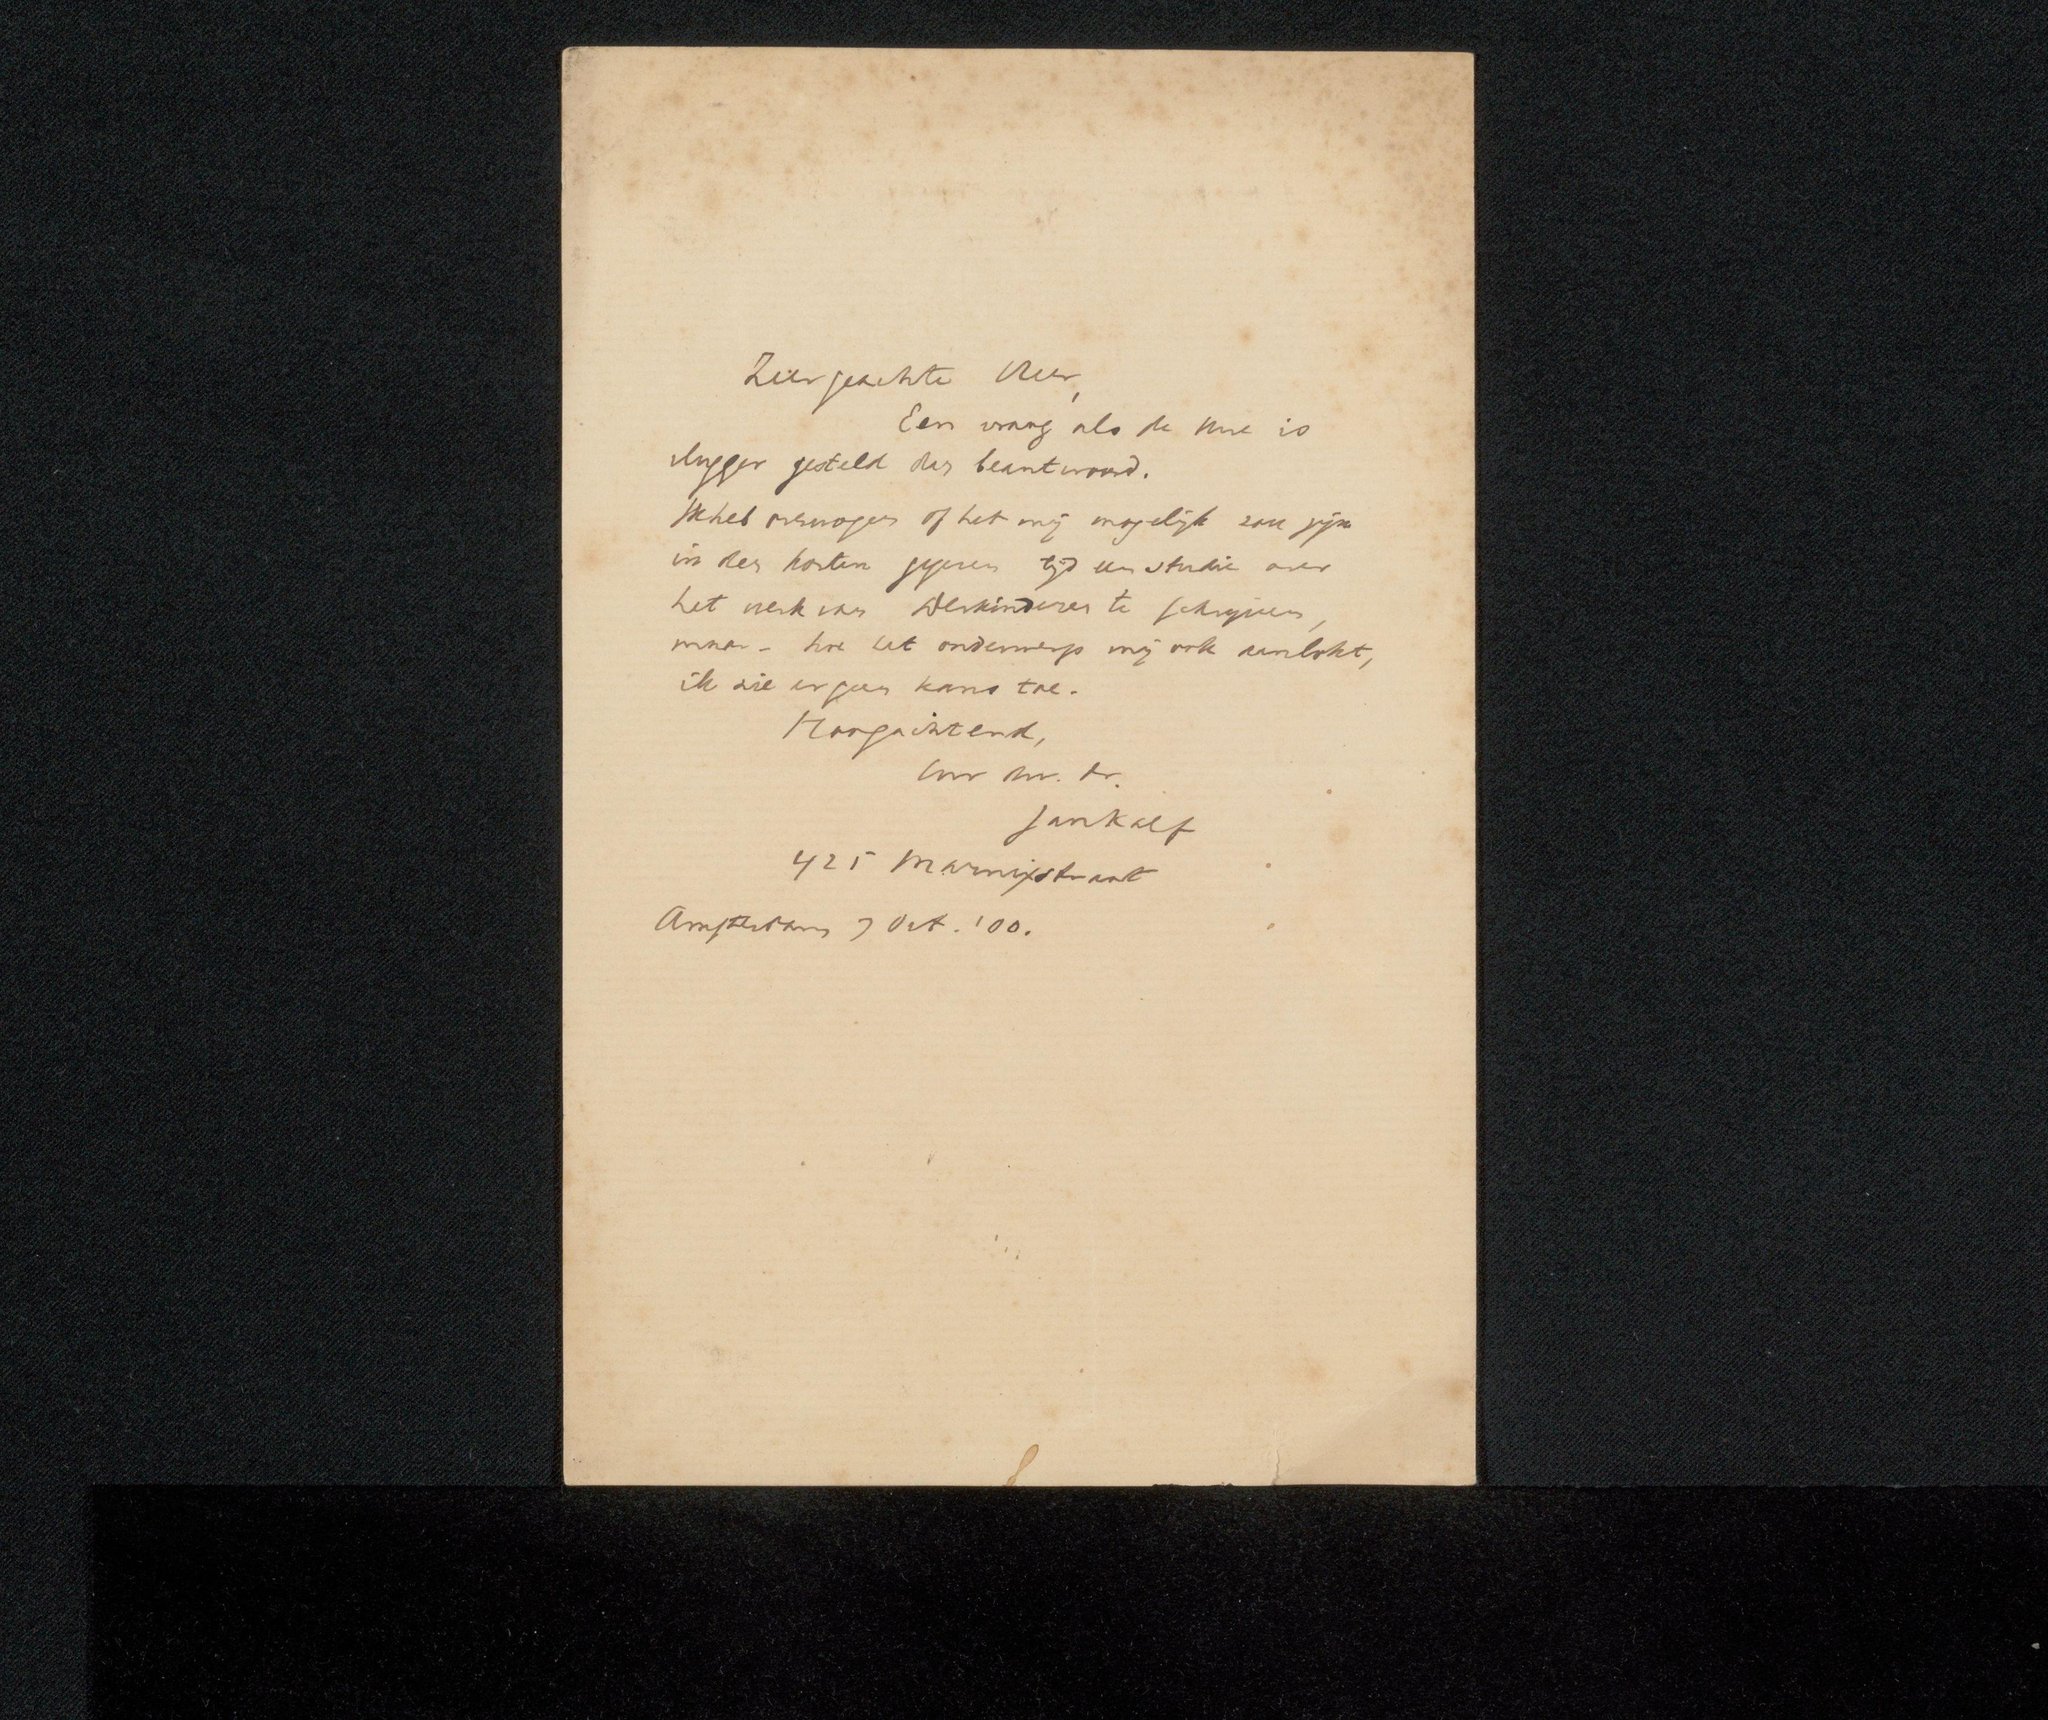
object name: letter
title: Brief aan Philip Zilcken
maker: jan kalf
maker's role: directeur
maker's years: 1873-1954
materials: ink, paper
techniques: pen, writing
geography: amsterdam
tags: den bosch, amsterdam, painter, print maker, draughtsman, antoon derkinderen, the hague, philip zilcken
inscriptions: collector's mark: ‘RPK’